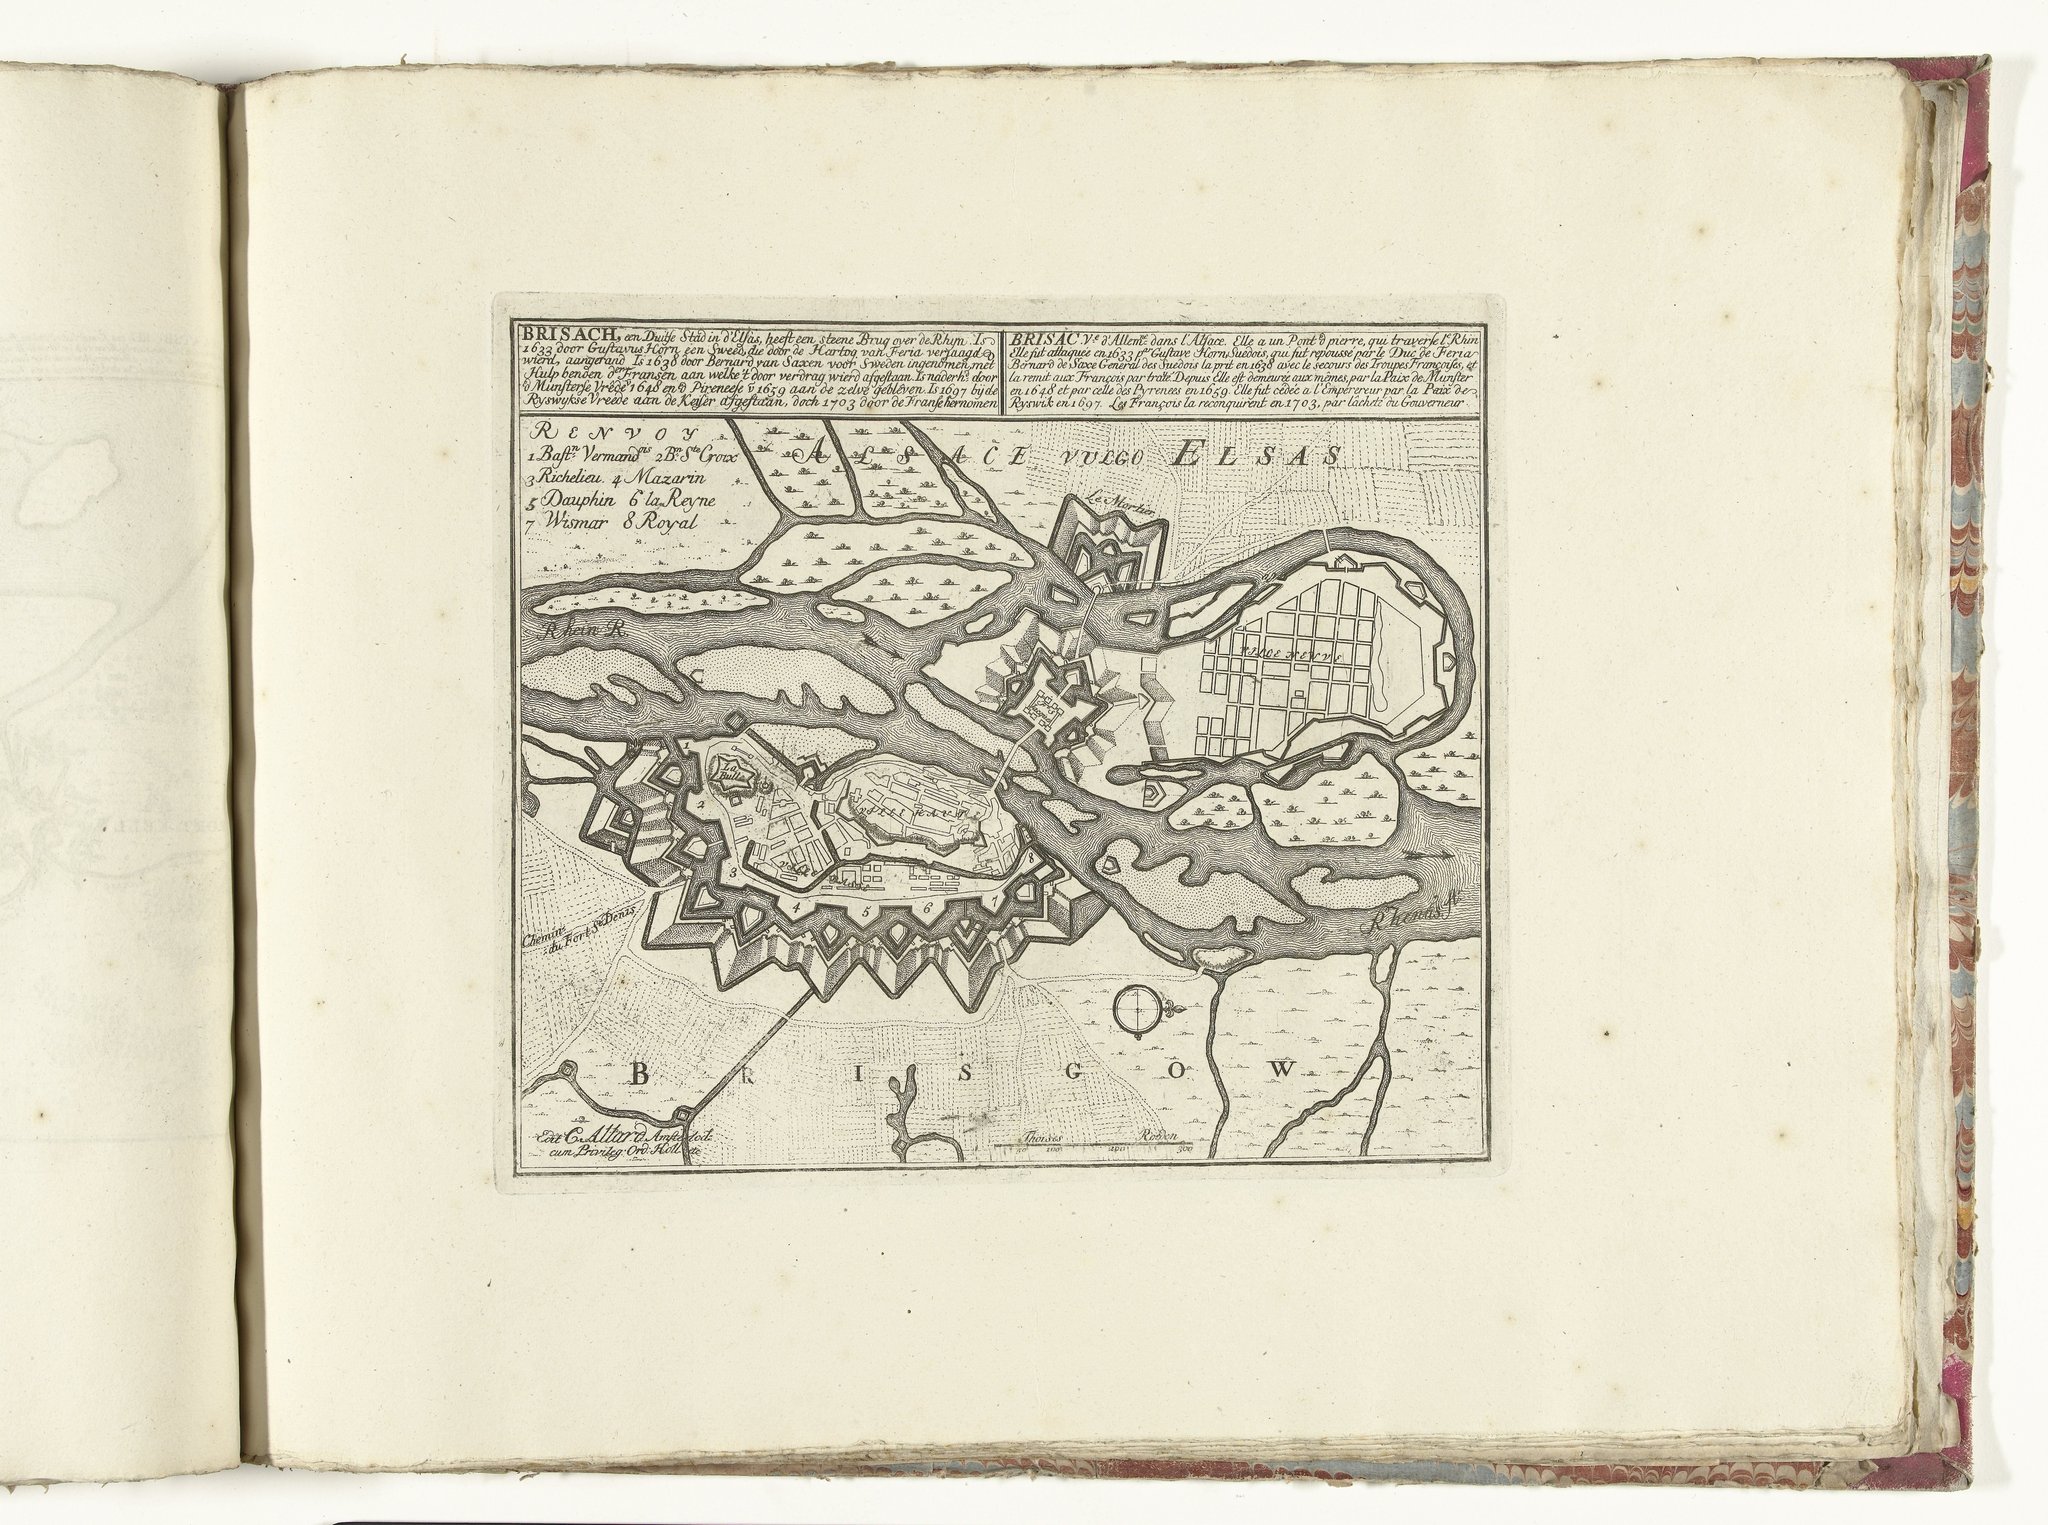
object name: map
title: Les Principales Forteresses & Villes Fortes, d'Espagne, de France, d'Italie, de Savoië, d'Allemagne & des Païs-Bas (...) / Naaukeurige Afbeeldingen der Voornaamste Sterke Steden en Vestingen in Spanjen, Vrankryk, Italien, Savoyen, Duytsland en Nederlanden (...)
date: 1703-1714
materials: paper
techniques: etching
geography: amsterdam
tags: maps of cities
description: Gekopieerd naar de Franse prenten in: Nicolas de Fer, Les forces de l'Europe, ou description des principales villes, avec leurs fortifications : dessignées par les meilleurs ingenieurs, particulierement celles ... de la France, dont les plans ont esté levez par M. de Vauban, Nicolas de Fer, Parijs 1693-1696, of andere voorbeelden.